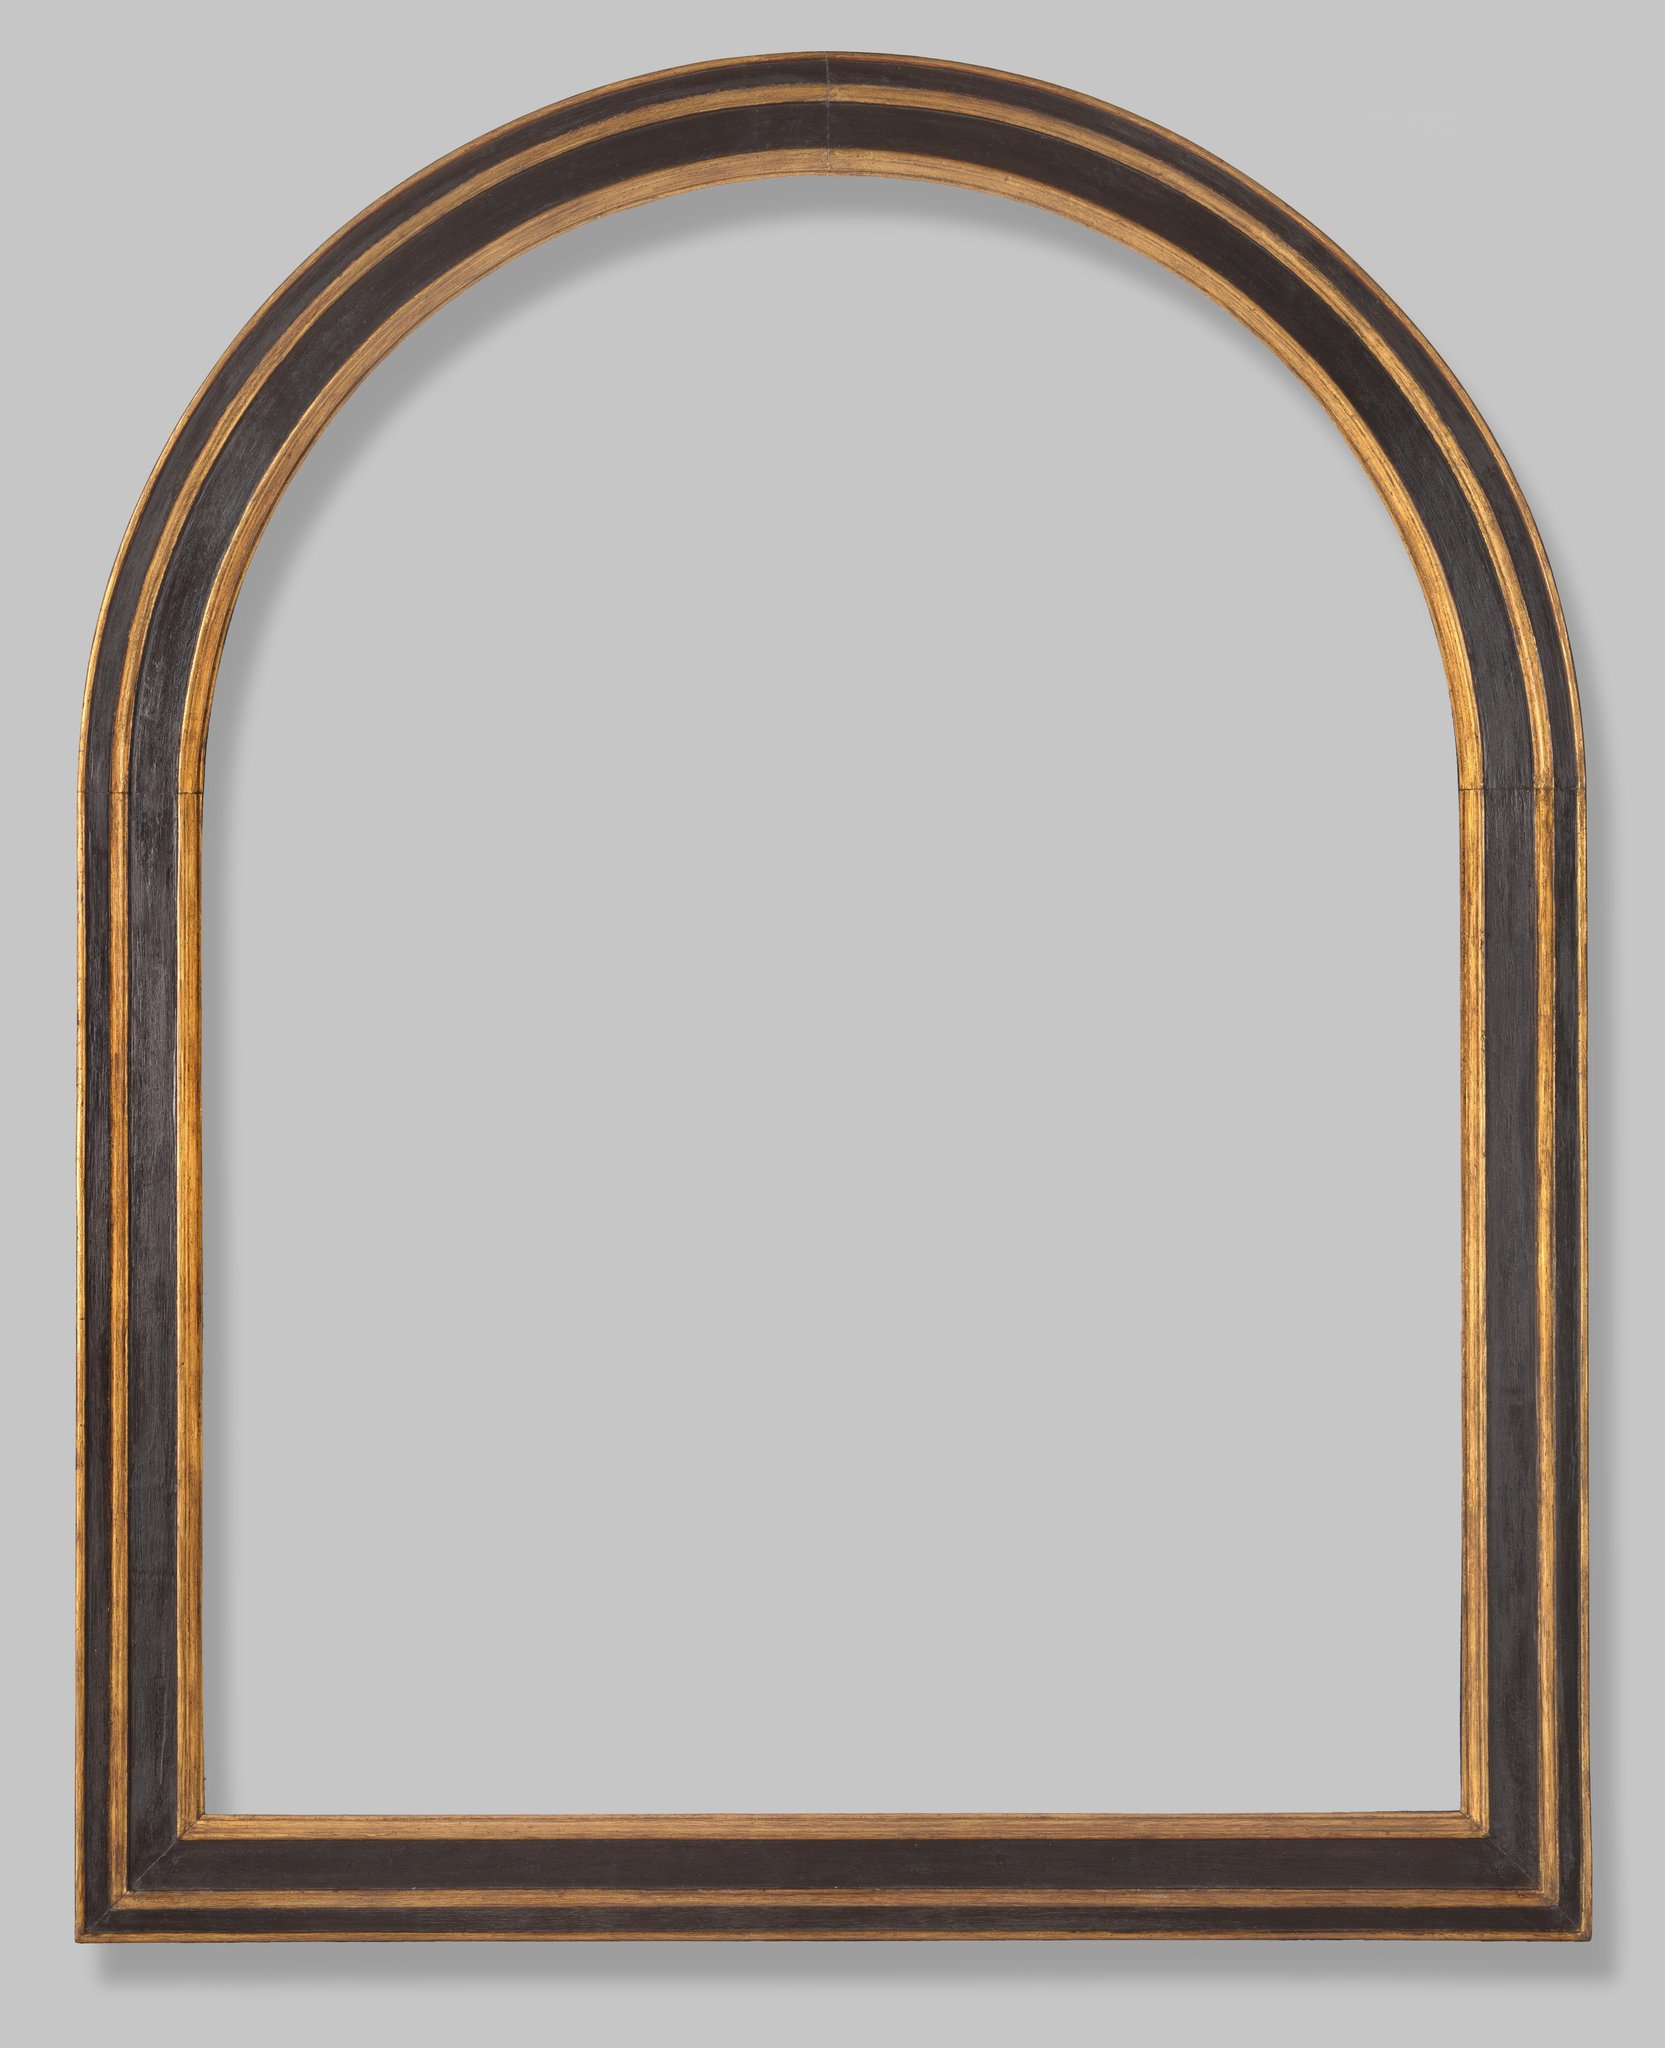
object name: frame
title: Gefineerde profiellijst met vlakke bodem en ronde toog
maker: Anonymous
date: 1900-1999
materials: wood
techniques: veneering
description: Profiellijst met vlakke bodem en ronde toog. Stijlen en regels zijn aan elkaar bevestigd met een halfhoutverbinding. De naaldhouten kern is gefineerd met eikenhout, de eikenhouten profieltjes geschraapt. De buitenrand/rug bestaat uit eikenhouten latjes die met schroeven en spijkers aan de kern zijn bevestigd.